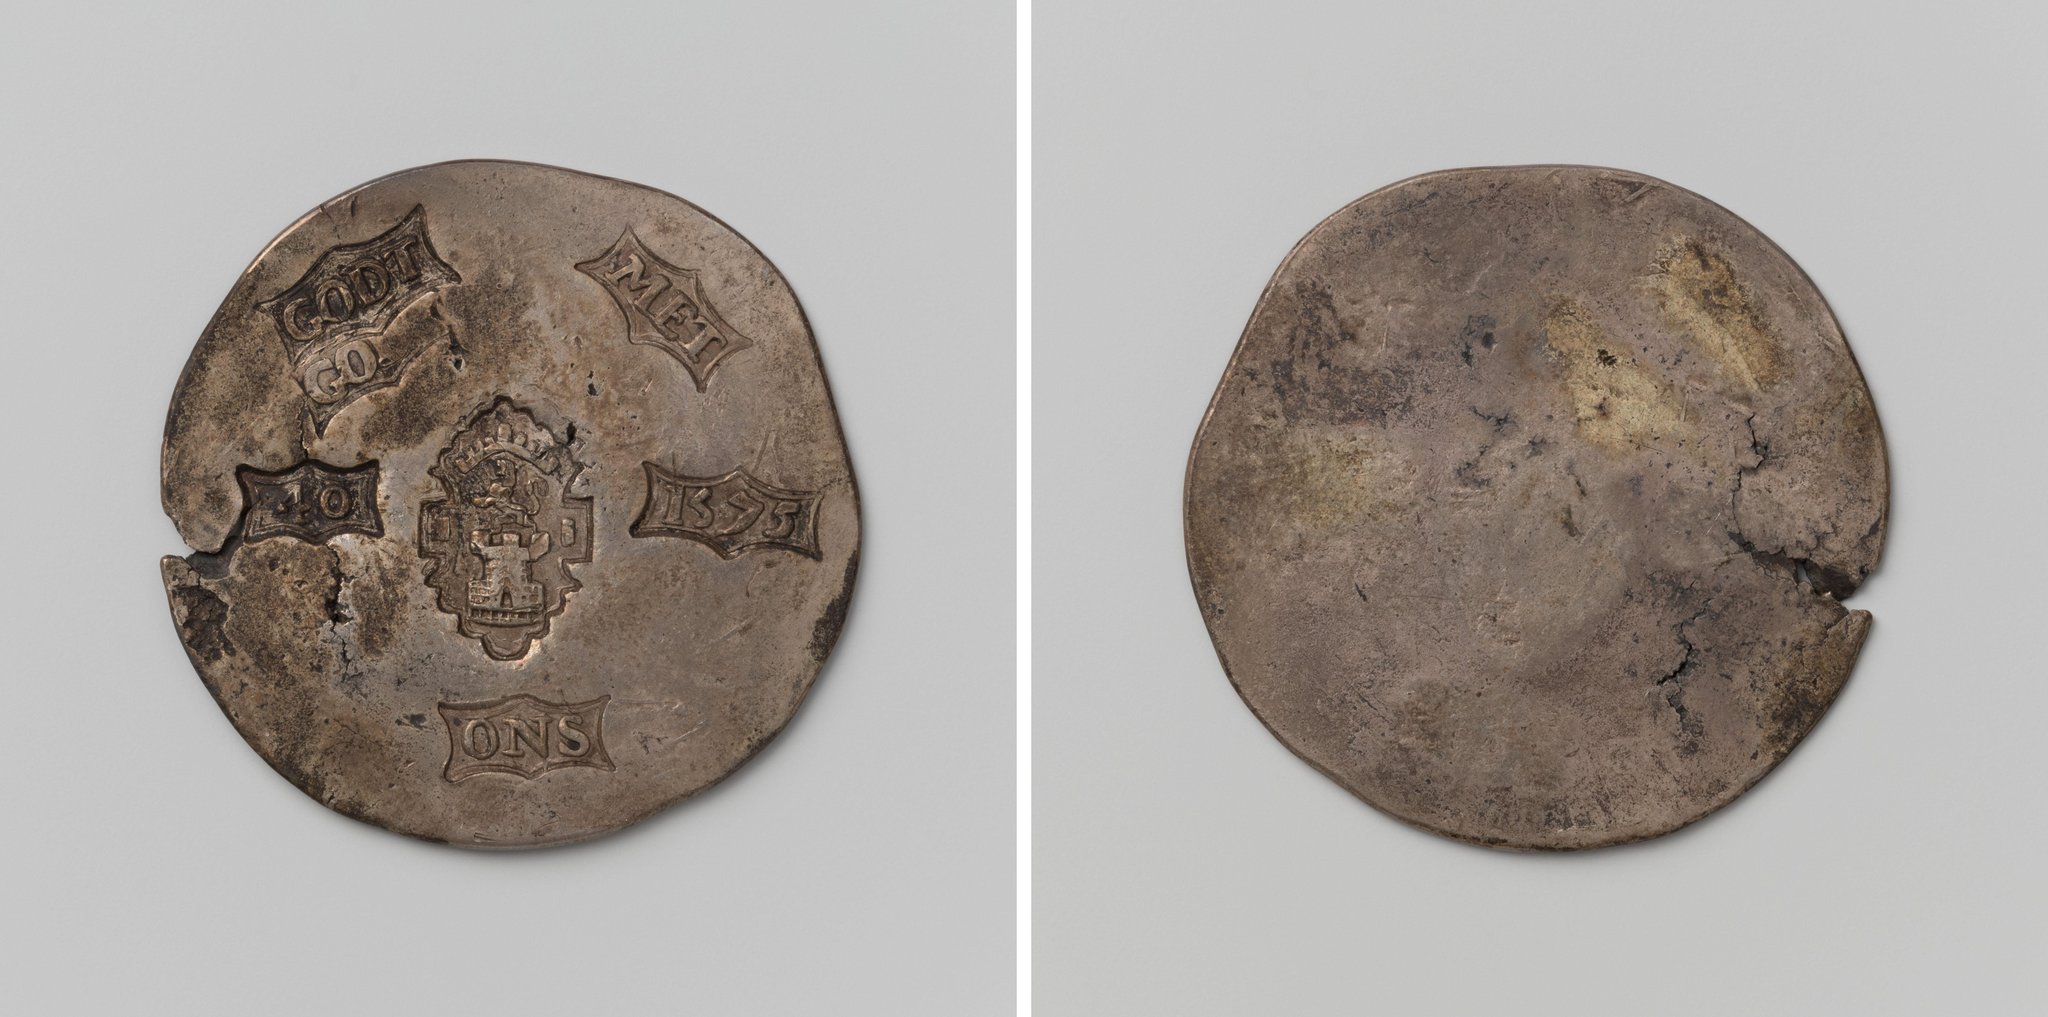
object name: coin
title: Veertig stuiver (kopie), noodmunt uit Oudewater, kopie van een munt geslagen tijdens het beleg, vervaardigd uit uitgehamerde (ondetermineerbare) munt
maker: Anonymous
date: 1883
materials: silver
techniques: striking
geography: oudewater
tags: oudewater, tachtigjarige oorlog, beleg van oudewater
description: eenzijdige noodmunt, latere vervalsing, midden links gescheurd. Voorzijde: zes stempels: rondom wapenschild opschrift bestaande uit drie verschillende stempels, waarvan stempel links boven tweemaal is ingeslagen; jaartal en cijfer 40. Keerzijde: blanco